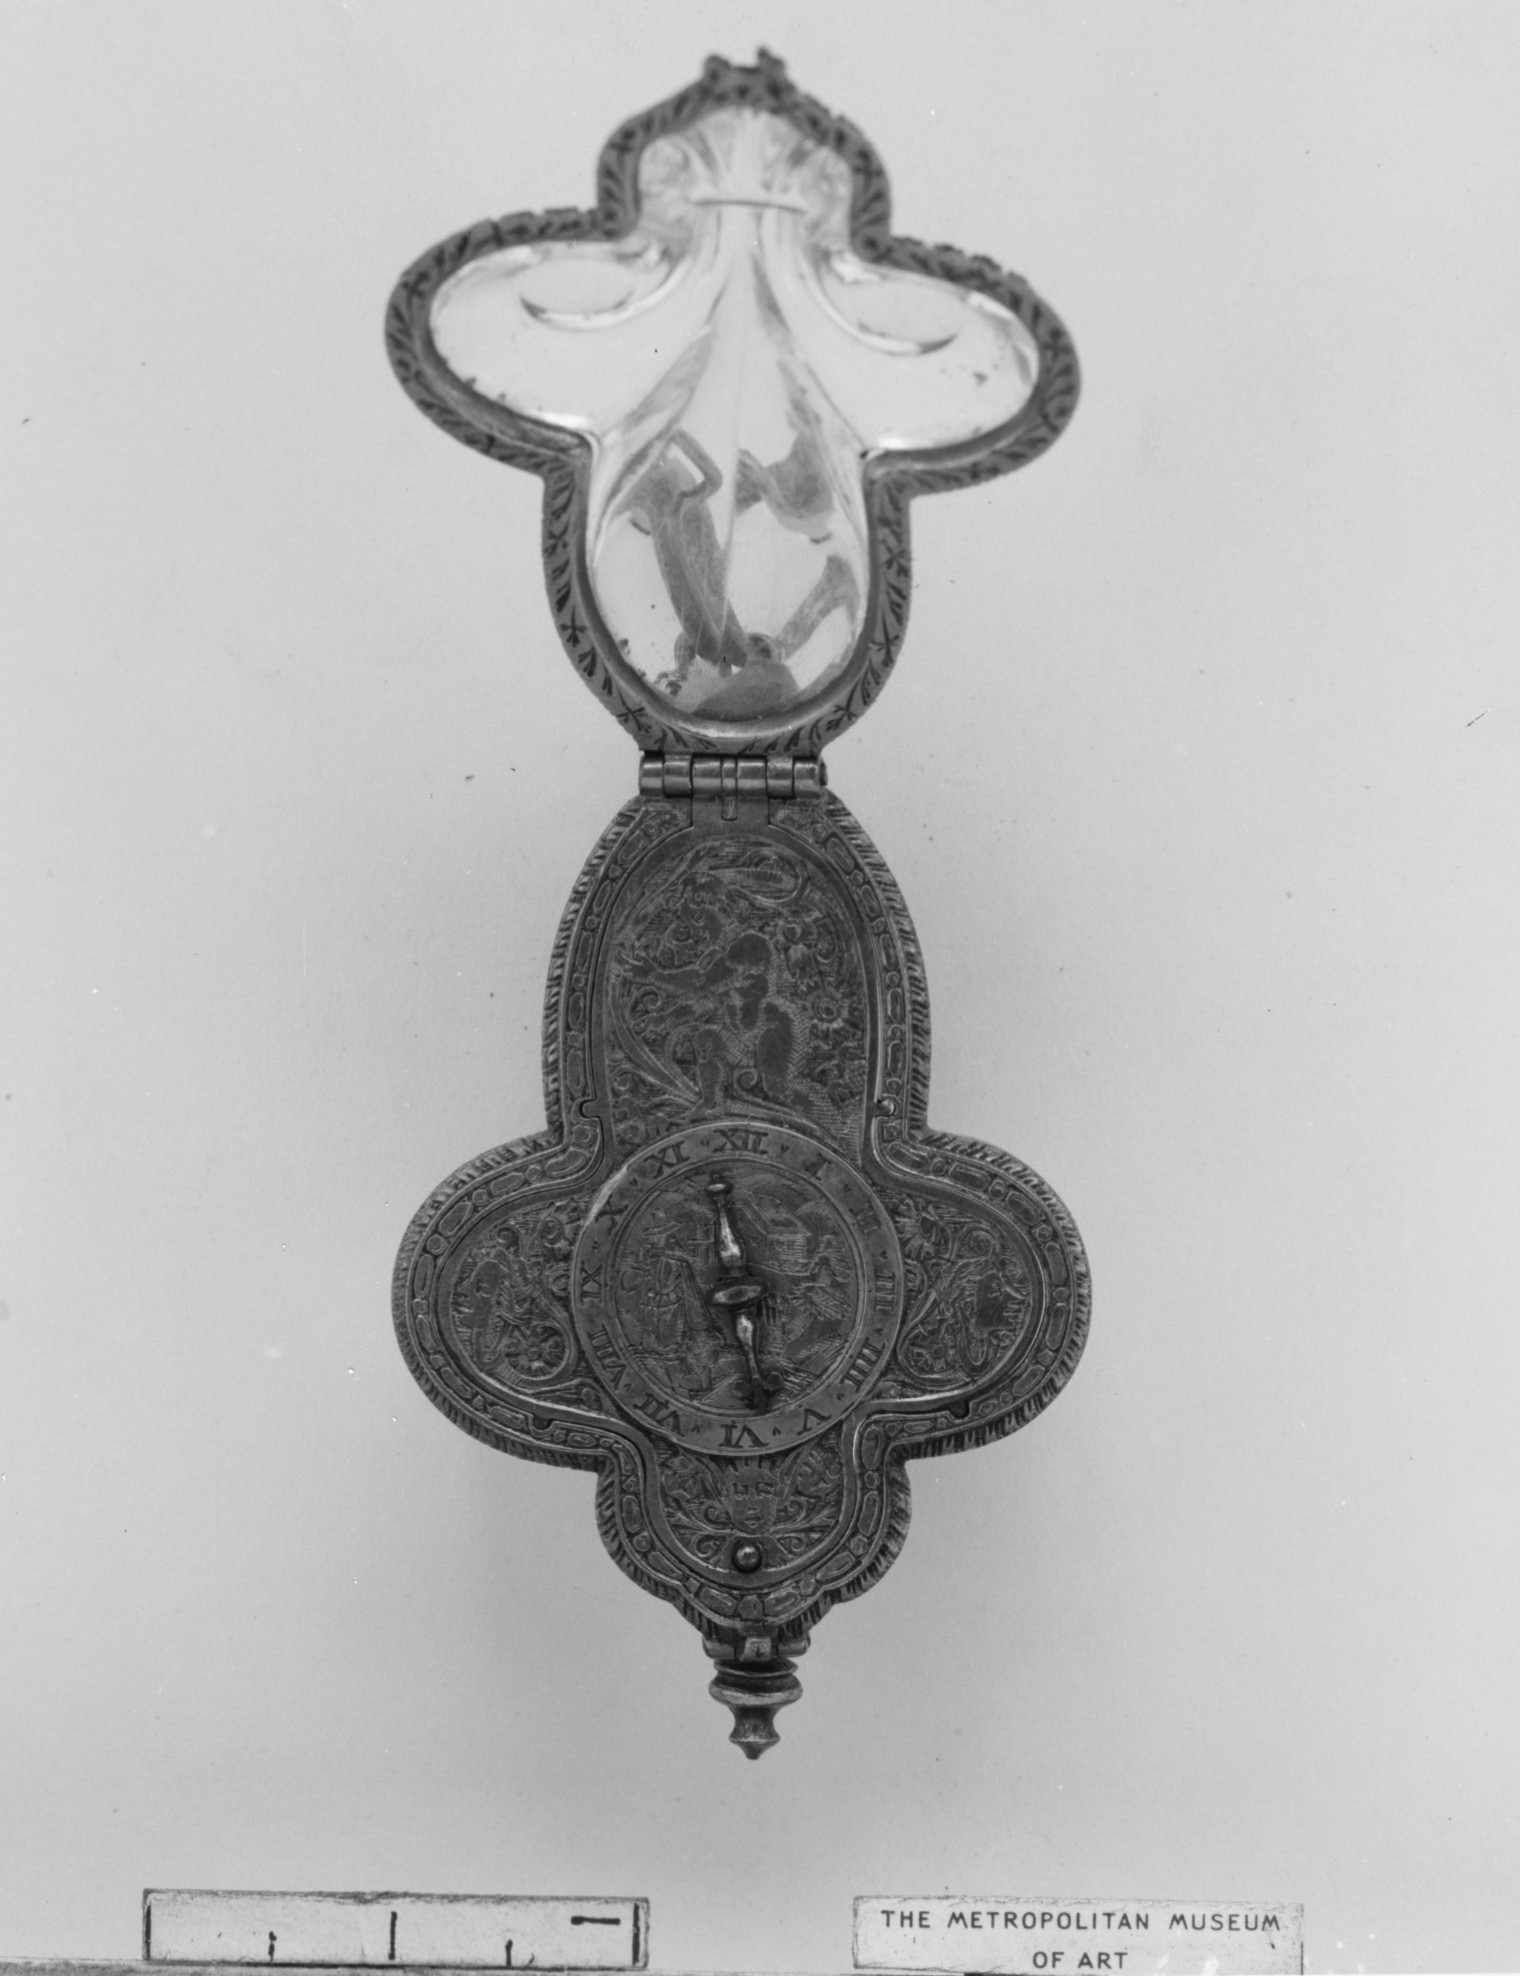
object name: watch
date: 1590-1620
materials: gilt, metal, quartz, silver